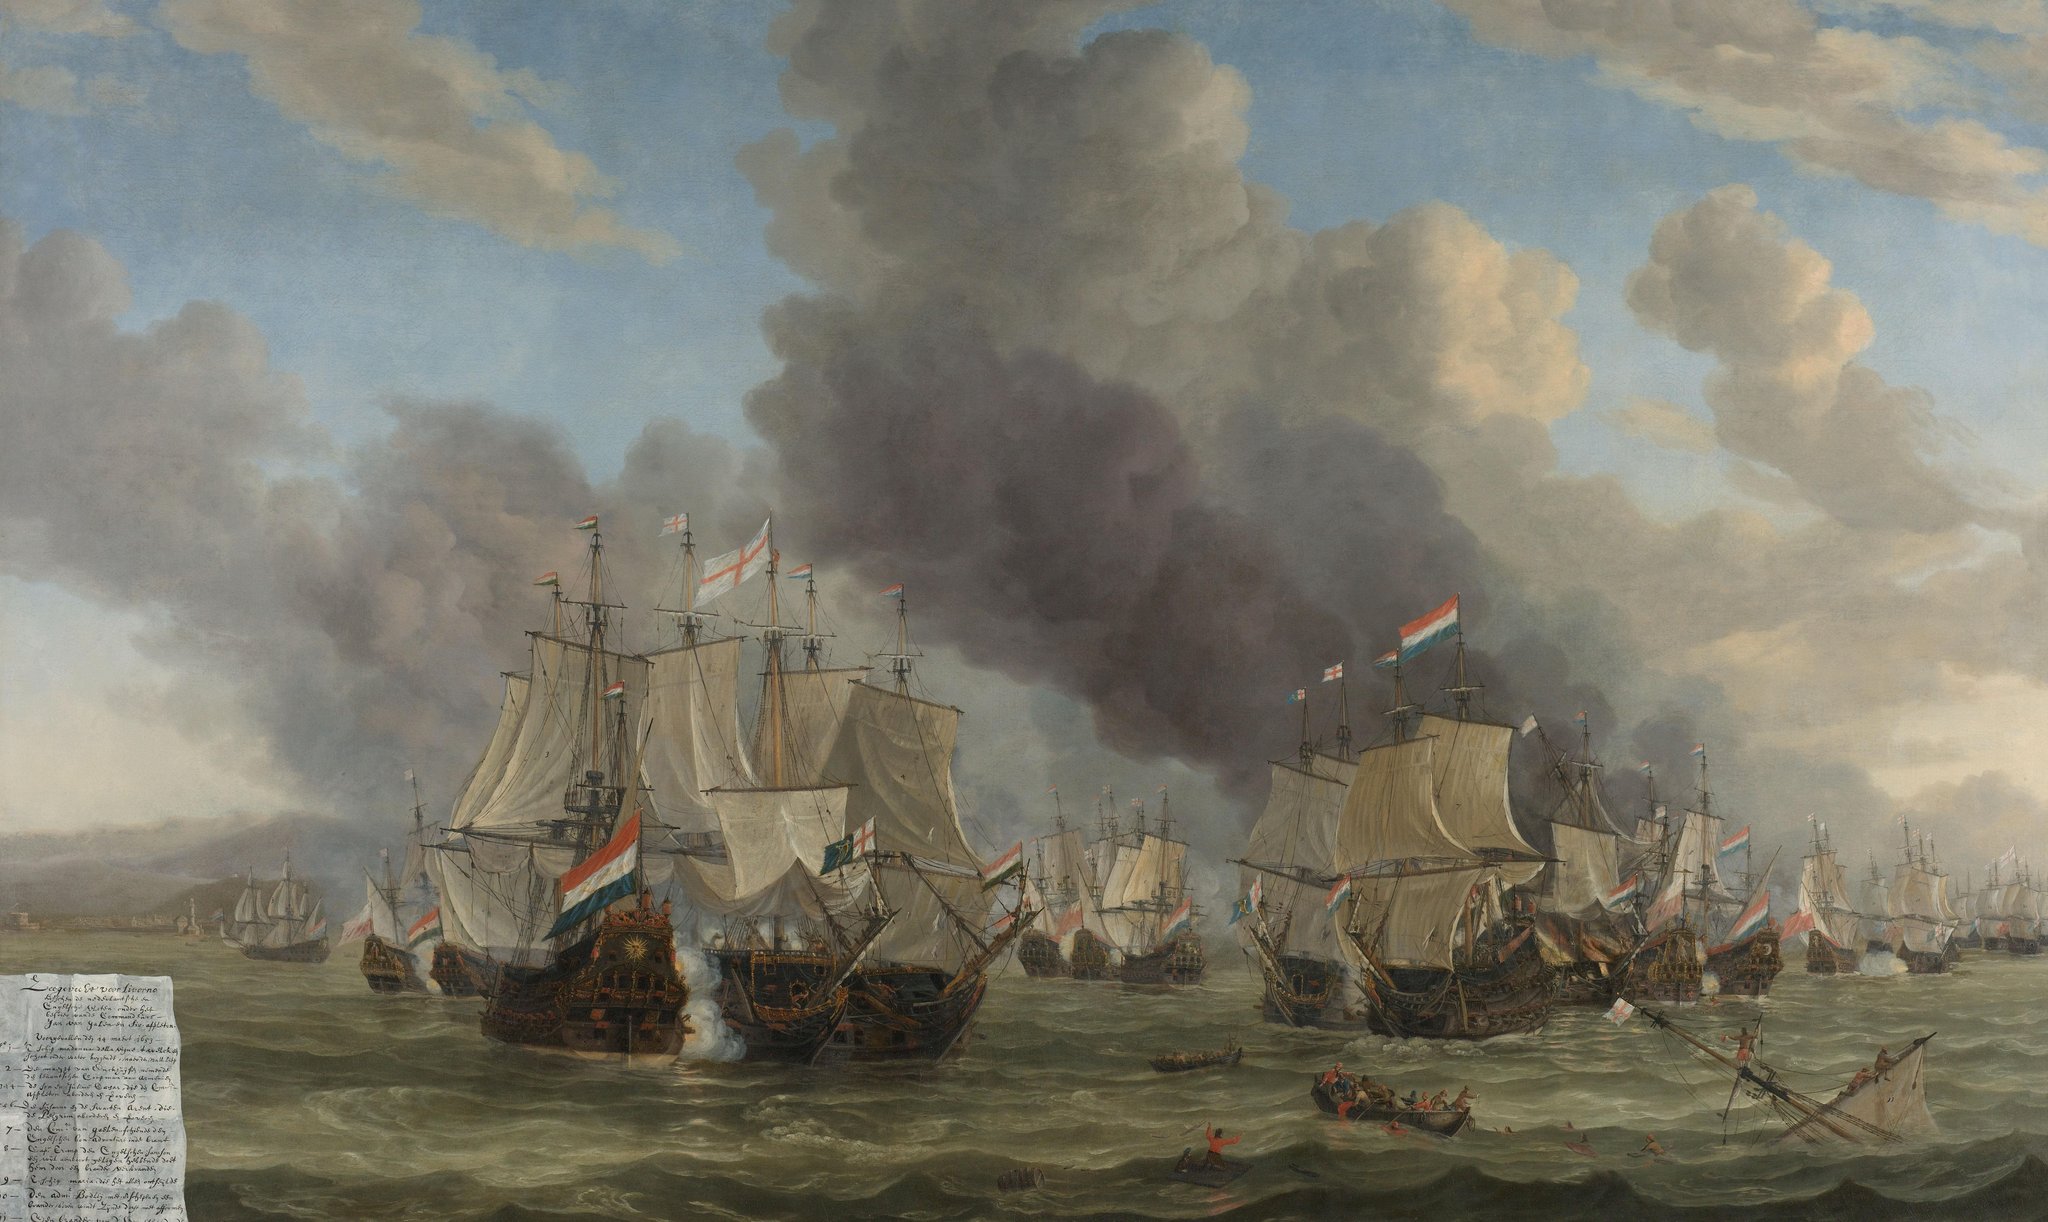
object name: painting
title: The Naval Battle near Livorno, 14 March 1653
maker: reinier nooms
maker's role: draughtsman, painter, print maker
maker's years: 1623-1664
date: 1653-1664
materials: canvas, oil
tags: rotterdam, cornelis tromp, essen, sailing-ship, sailing-boat, battle (+ naval force), battle of leghorn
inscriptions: signature: ‘R: Zeeman’, inscription: ‘Zeegevecht voor Livorno tusschen de nederlantsche en Engelsche vloten onder het bestier van de Commandeurs Jan van Galen en Sir Appleton. Voorgevallen den 14. maert 1653 / Nº 1 - 'T Schip madonna della vigne - 't welck een schoot onder water krijgende, naer de wall liep / 2 - De maeght van Enckhuijsen nemende den Levantschen Coopman van Armenien / 3 & 4 - De Son en Julius Caesar, die ten Com:er Appleton aborderen en veroveren / 5 & 6 - De Suzanna en de Swarten Arent, die de Pelgrim aborderen en veroveren / 7 - Den Com.er van Gaelen schiende den - Engelschen bonadvonture in de brant / 8 - Cap.n Tromp den Engelschen Samson een wijl aenbort gelegen hebbende doet hem door een brander verbranden / 9 - 'T Schip Maria, die het alleen ontscijlde / 10 - Den adm:l Bodley, met 8 schepen en een brander, boven windt zijnde dorst niet affcomen / 11 - Een brander van d'Engelsche door den Com.er van galen in de gront geschooten.’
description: A painted sheet of paper at the lower left describes the subject: the battle between the Dutch and English fleets off the Italian port of Livorno (Leghorn). Victory brought the Dutch control over trade in the Mediterranean. Nooms almost certainly painted the canvas for the Chamber of Levantine Trade in Amsterdam.